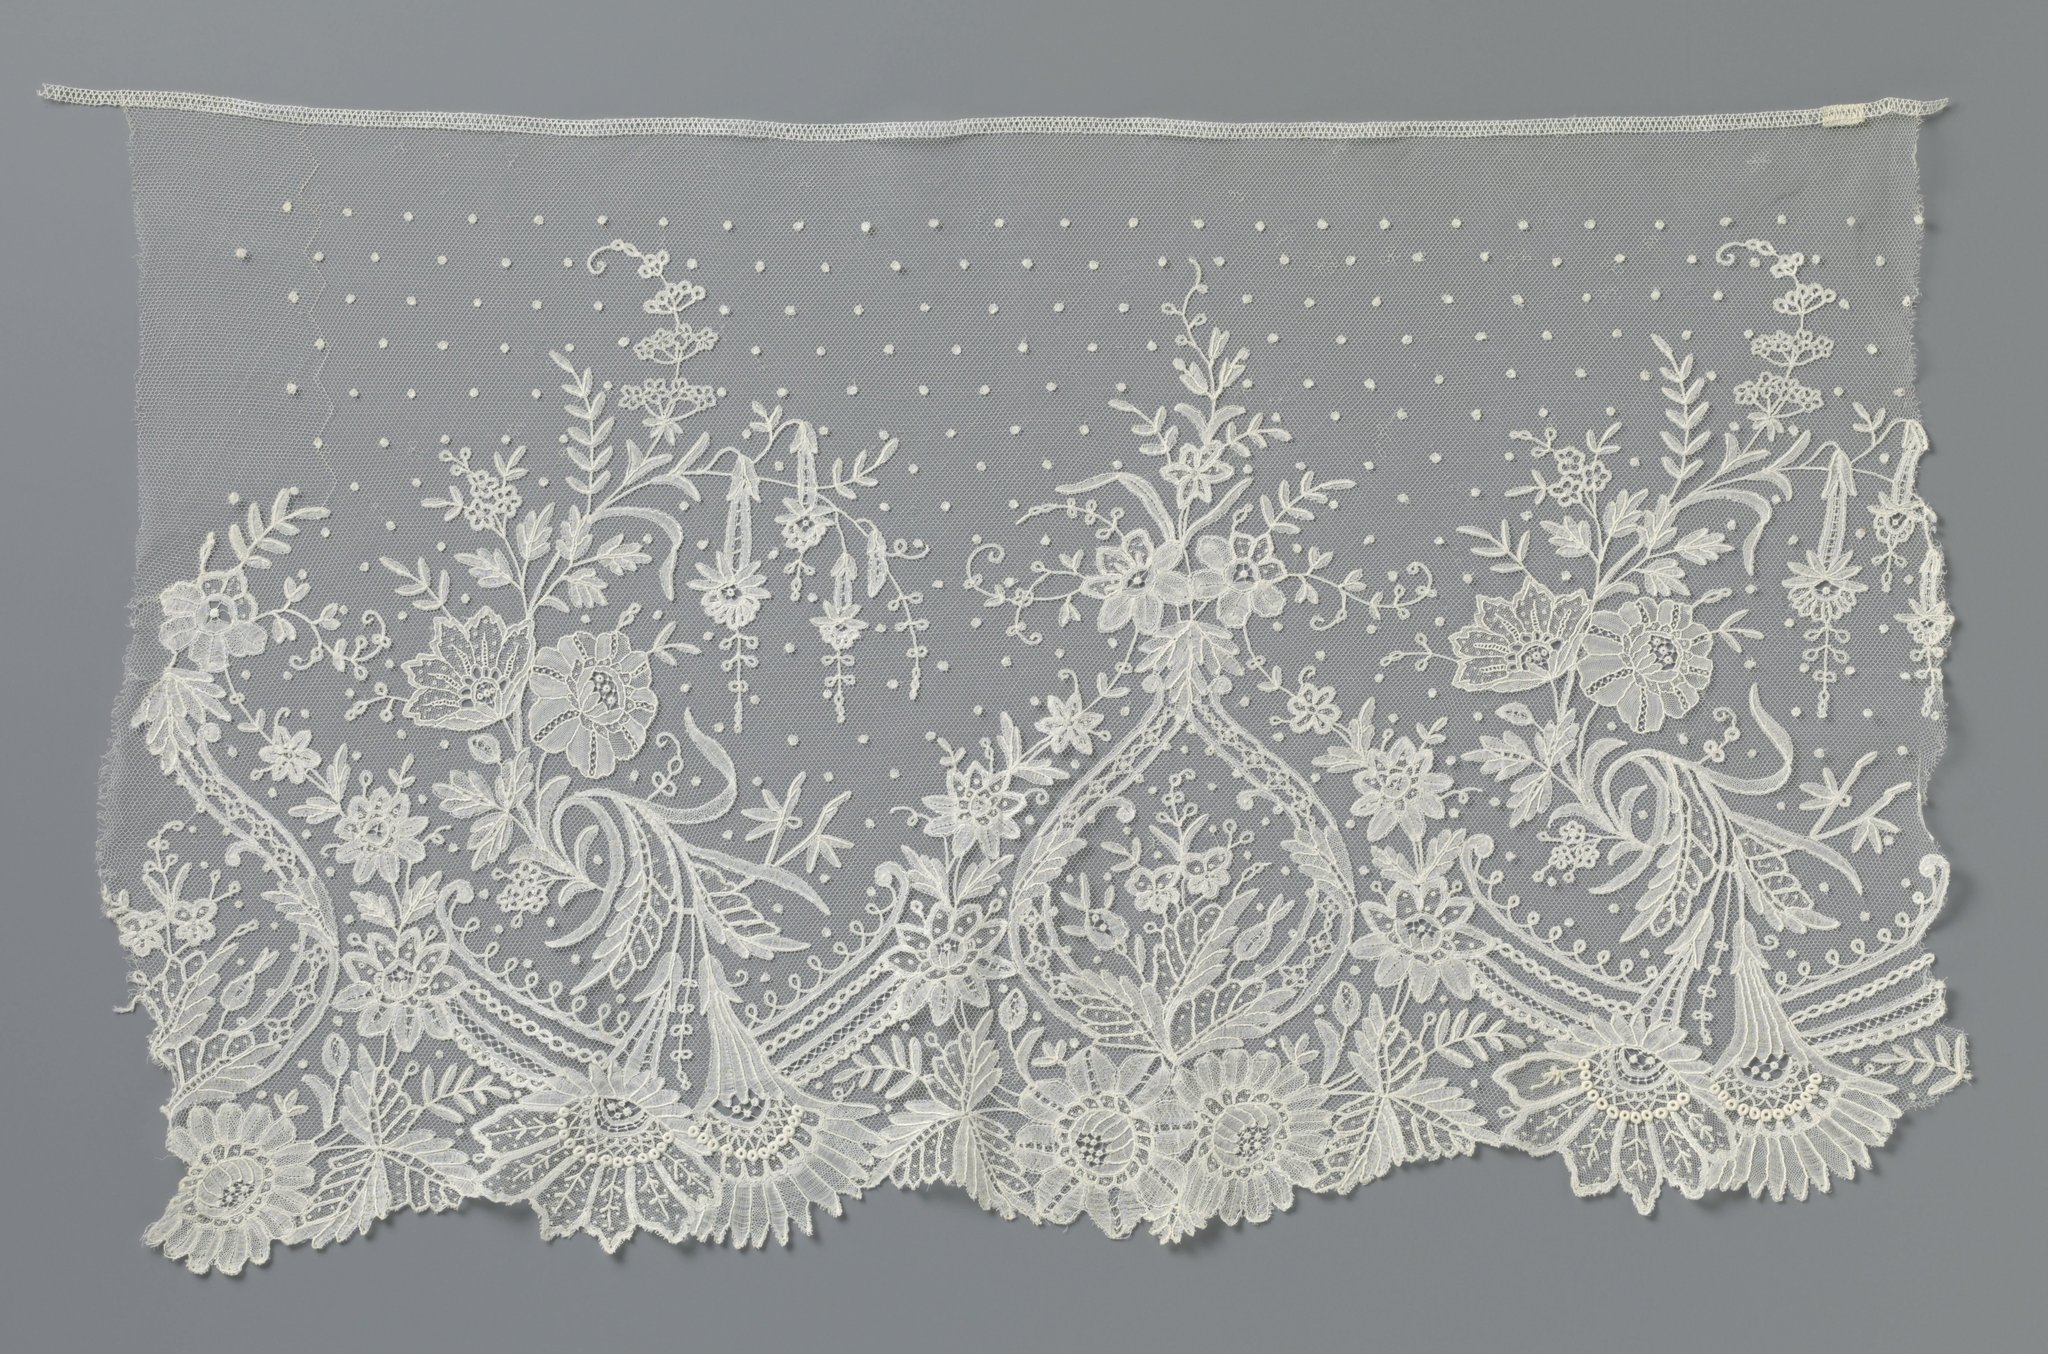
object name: strip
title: Japonstrook van applicatiekant met de peervormige medaillons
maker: Anonymous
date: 1850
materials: linen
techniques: lace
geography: brussels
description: Japonstrook van naturelkleurige applicatiekant, kloskant en naaldkant geappliceerd op machinale tule. Tegen een achtergrond, die wijd bezaaid is met moesjes, zijn gesloten gewerkte schulpen beurtelings gevuld met een peervormig medaillon met viooltjes en een cirkelboog met een bloemtak. De peervorm is omgeven door een bloemkrans met een bloemtakje in de top. De tak boven de cirkelboog is c-vormig gezwenkt en vertoont twee grote afhangende kelkbloemen, een duinroosje en een anemoon (beide van naaldkant) en hangende klokjes.